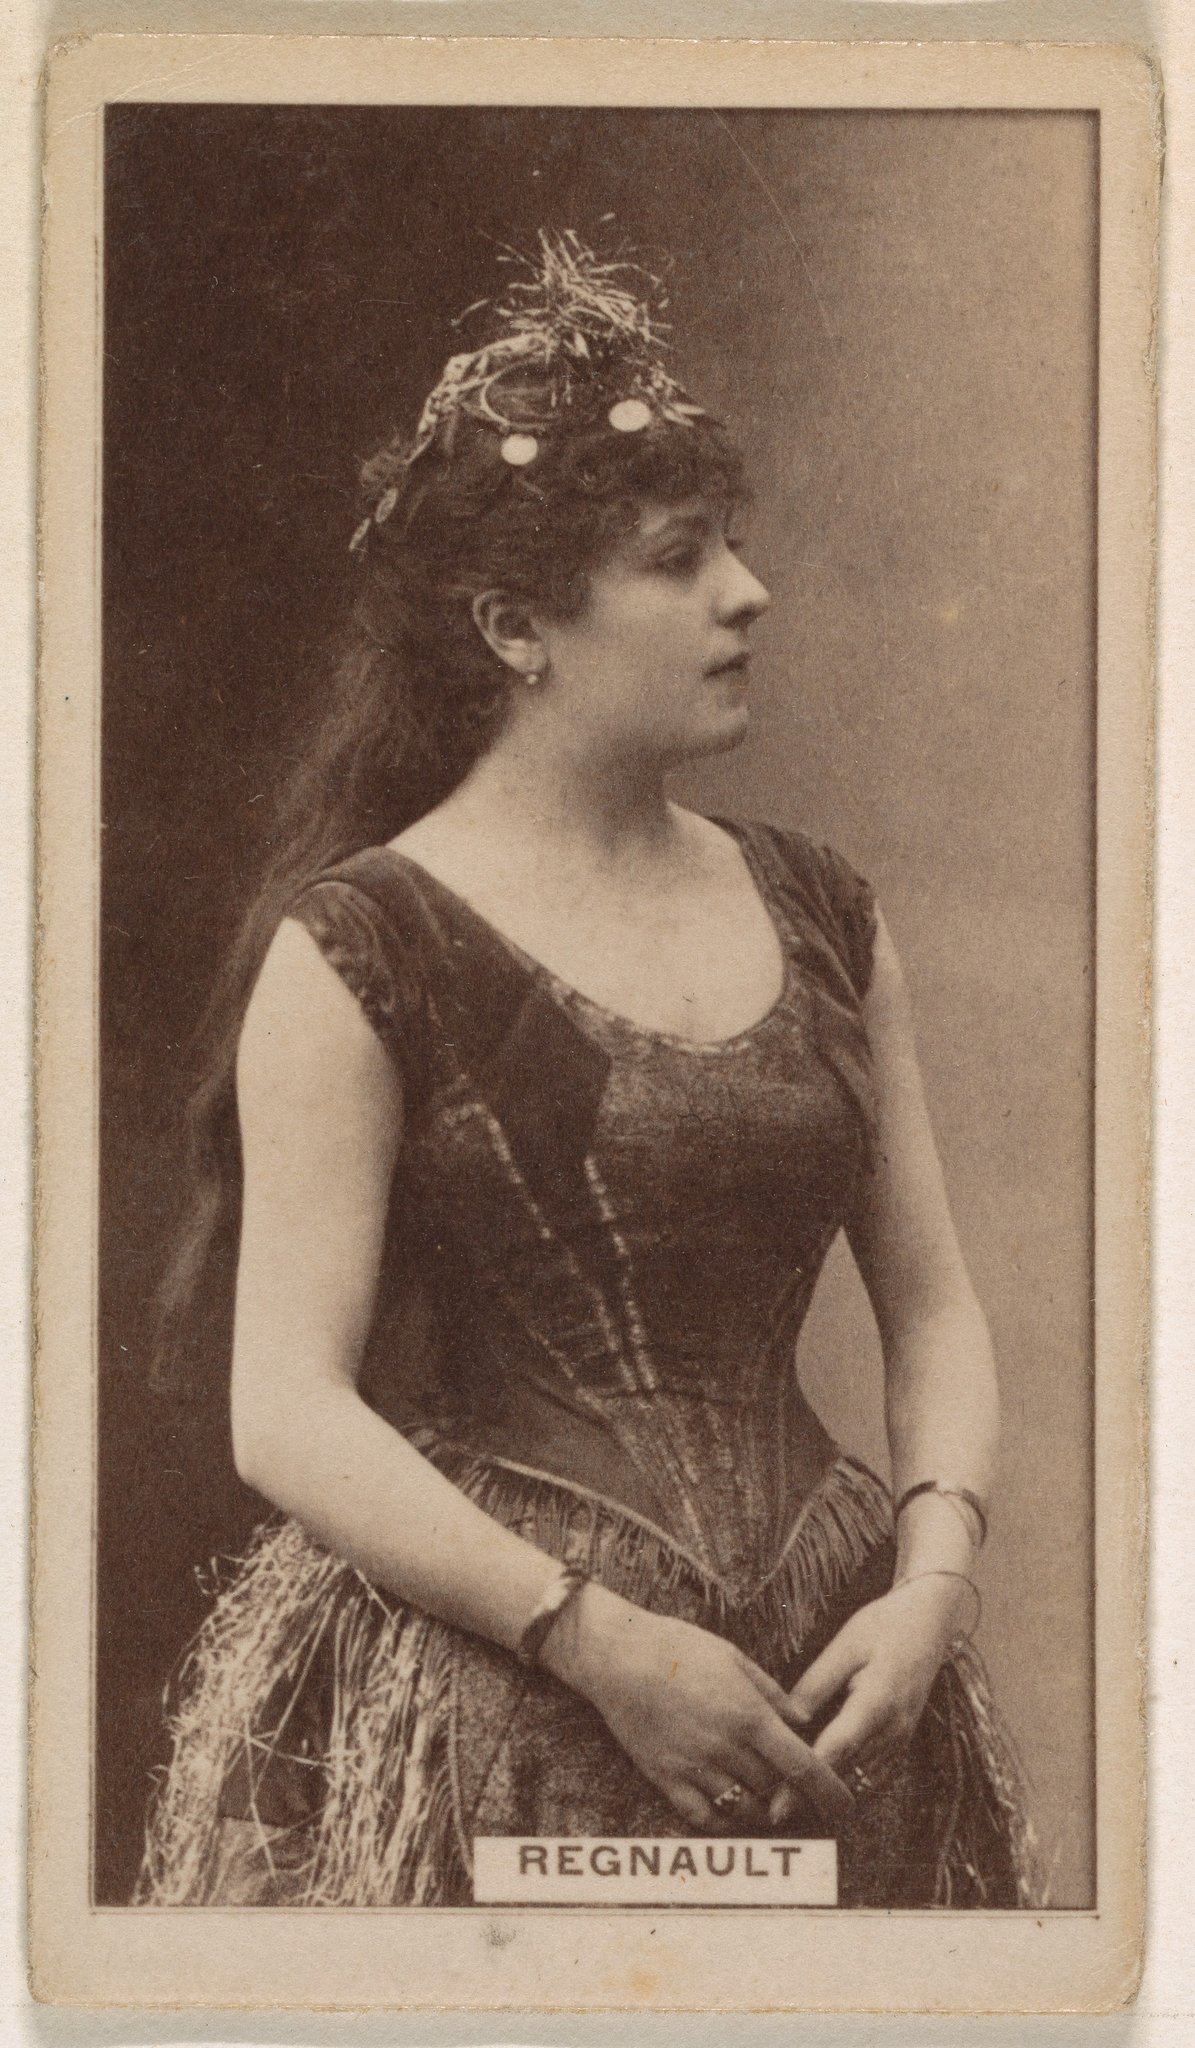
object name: photograph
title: Miss Regnault, from the Actresses series (N245) issued by Kinney Brothers to promote Sweet Caporal Cigarettes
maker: kinney brothers tobacco company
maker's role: publisher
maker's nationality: american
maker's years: 1869-2011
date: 1890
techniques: albumen silver print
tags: women,actresses